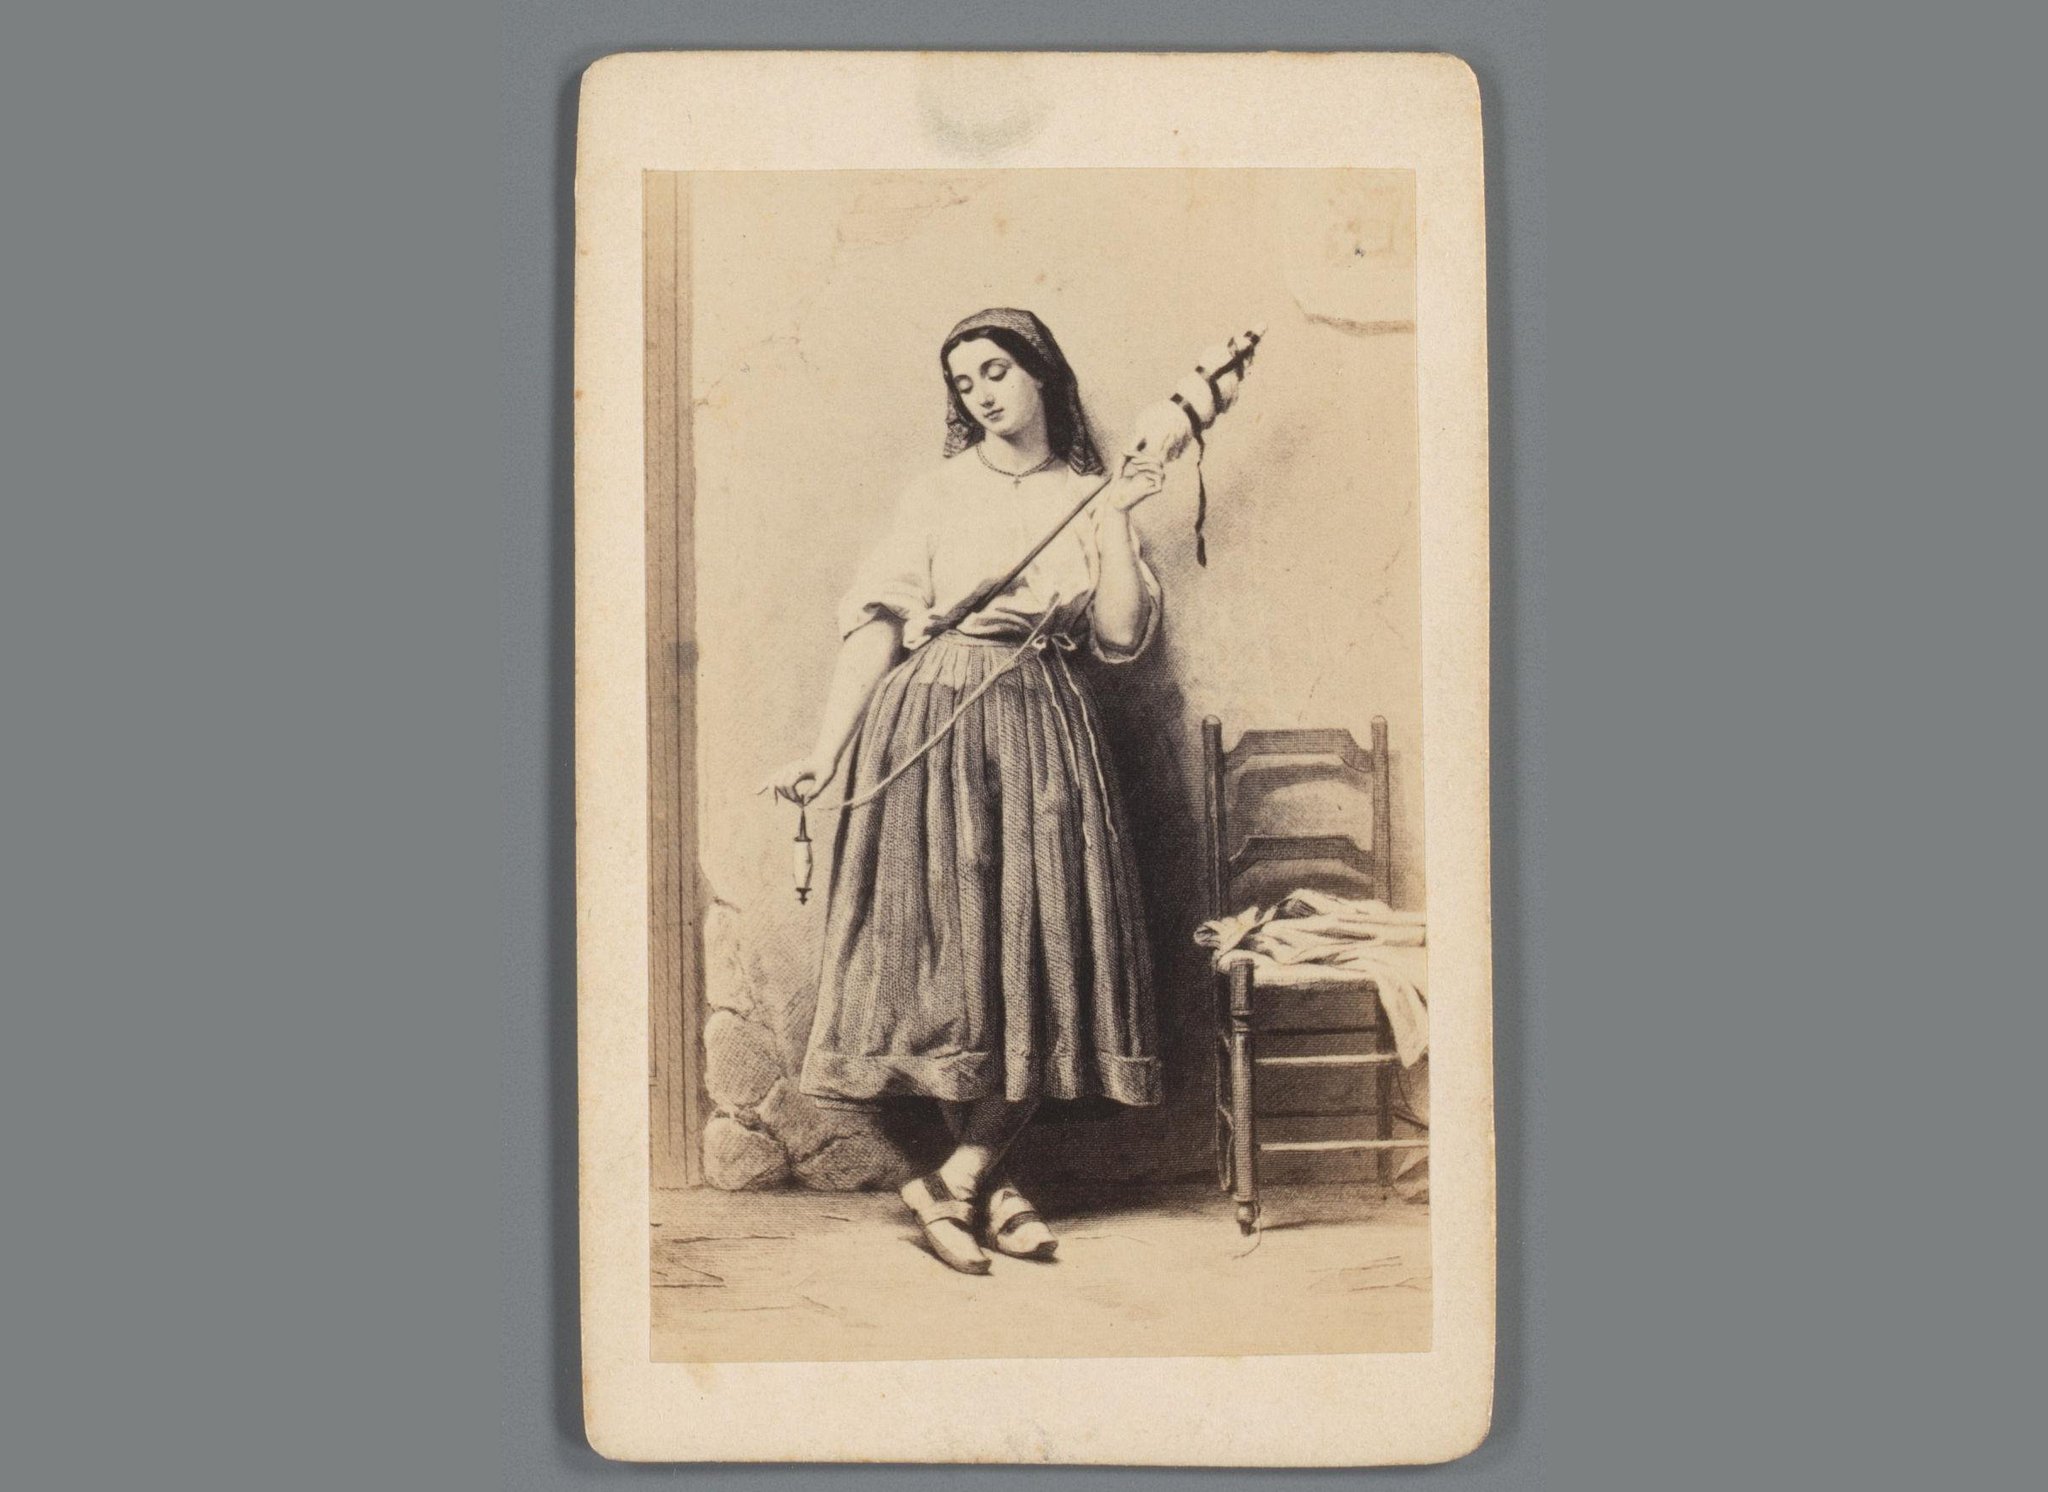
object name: carte de visite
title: Fotoreproductie van een prent van een boerenvrouw die garen spint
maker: Anonymous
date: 1870-1900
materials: cardboard, paper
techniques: albumen print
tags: adolescent, young woman, maiden, spinning (manufacture of yarn)